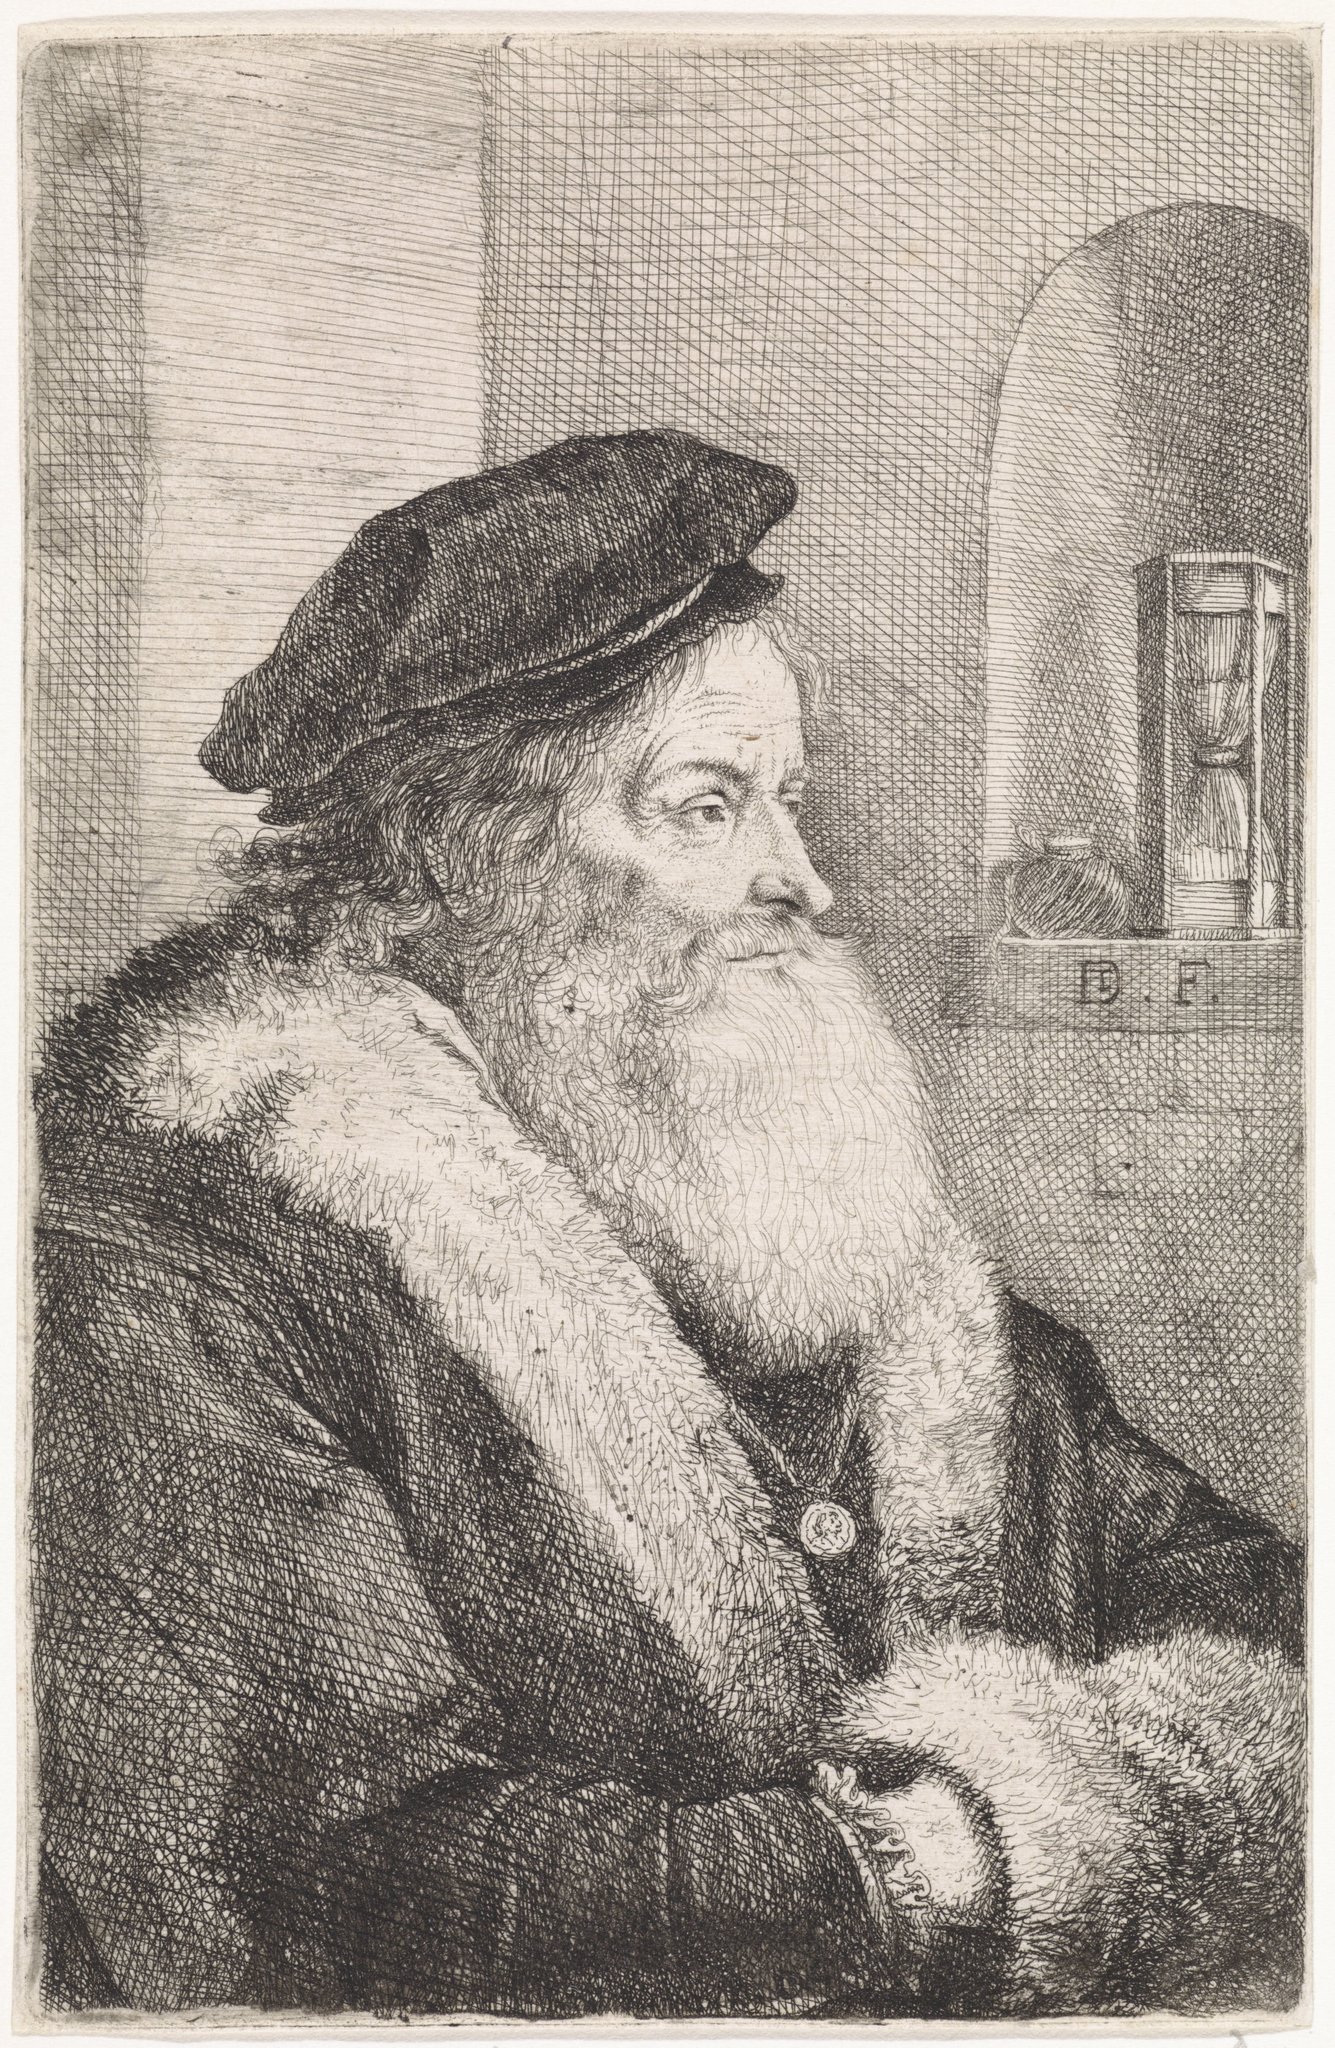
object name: print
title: Oude man met baard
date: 1626-1740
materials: paper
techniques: etching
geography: low countries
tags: muff, head-gear: cap (+ men's clothes), hourglass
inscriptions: collector's mark: Lugt 240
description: Een oude man met baard en een baret op het hoofd houdt zijn handen in een mof. In de nis staat een zandloper.